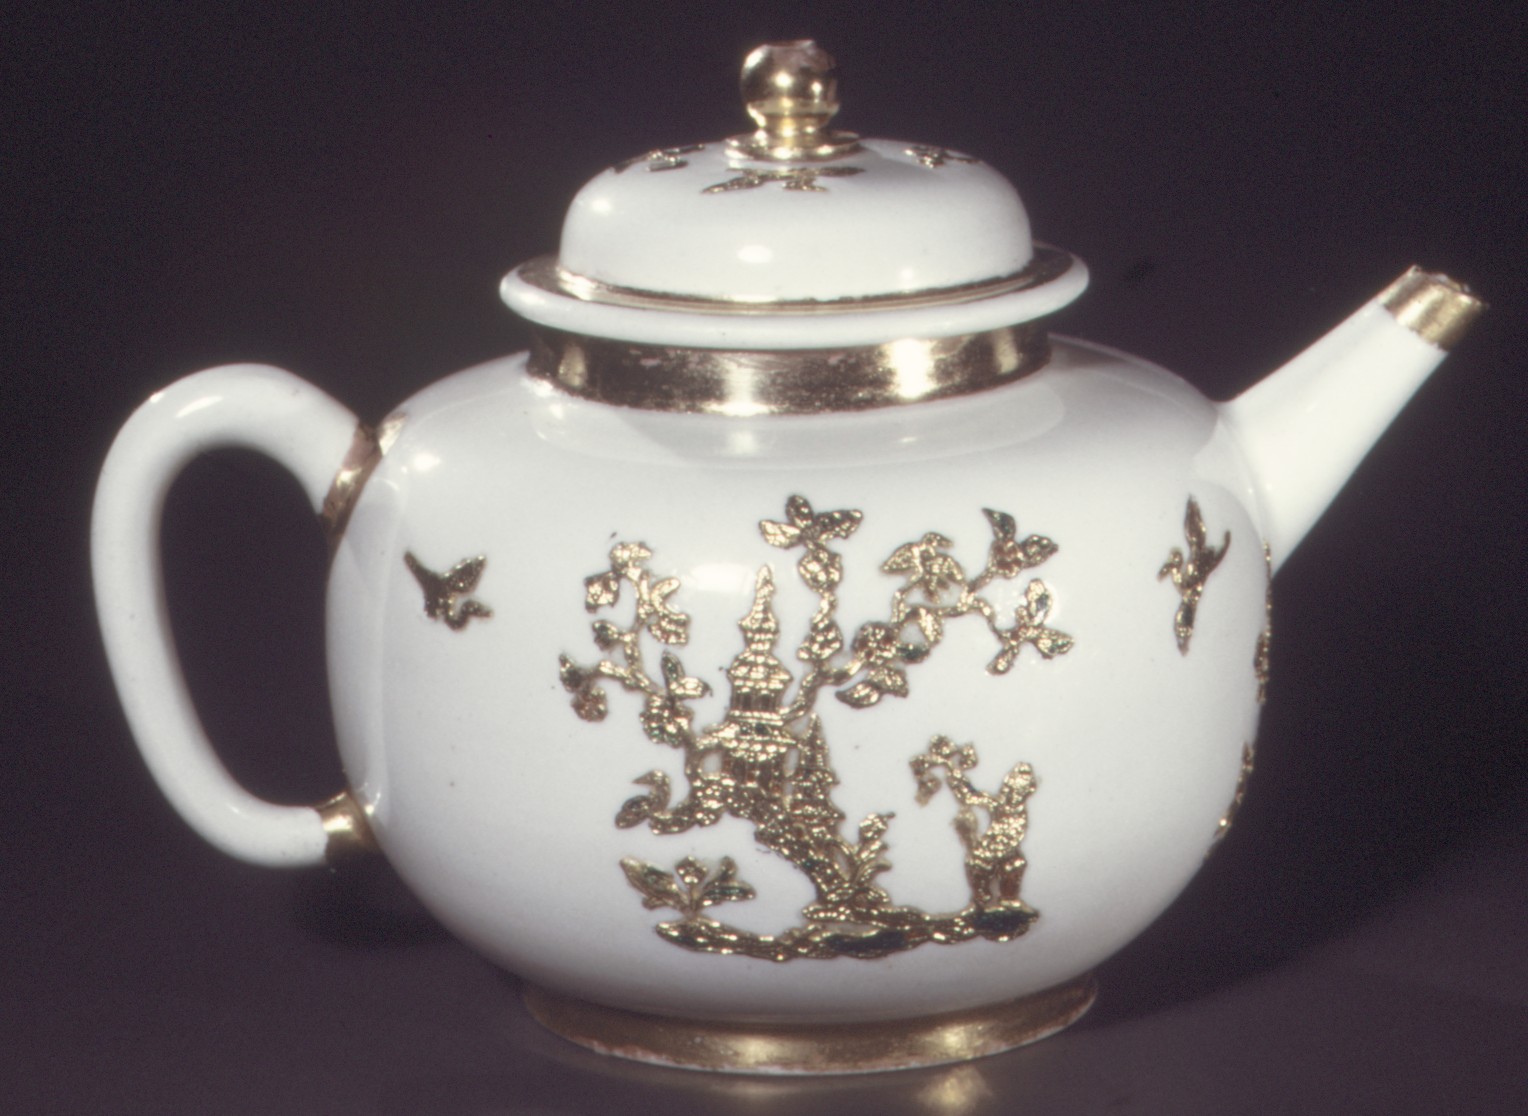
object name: teapot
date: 1720-1730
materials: hard paste porcelain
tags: birds,flowers